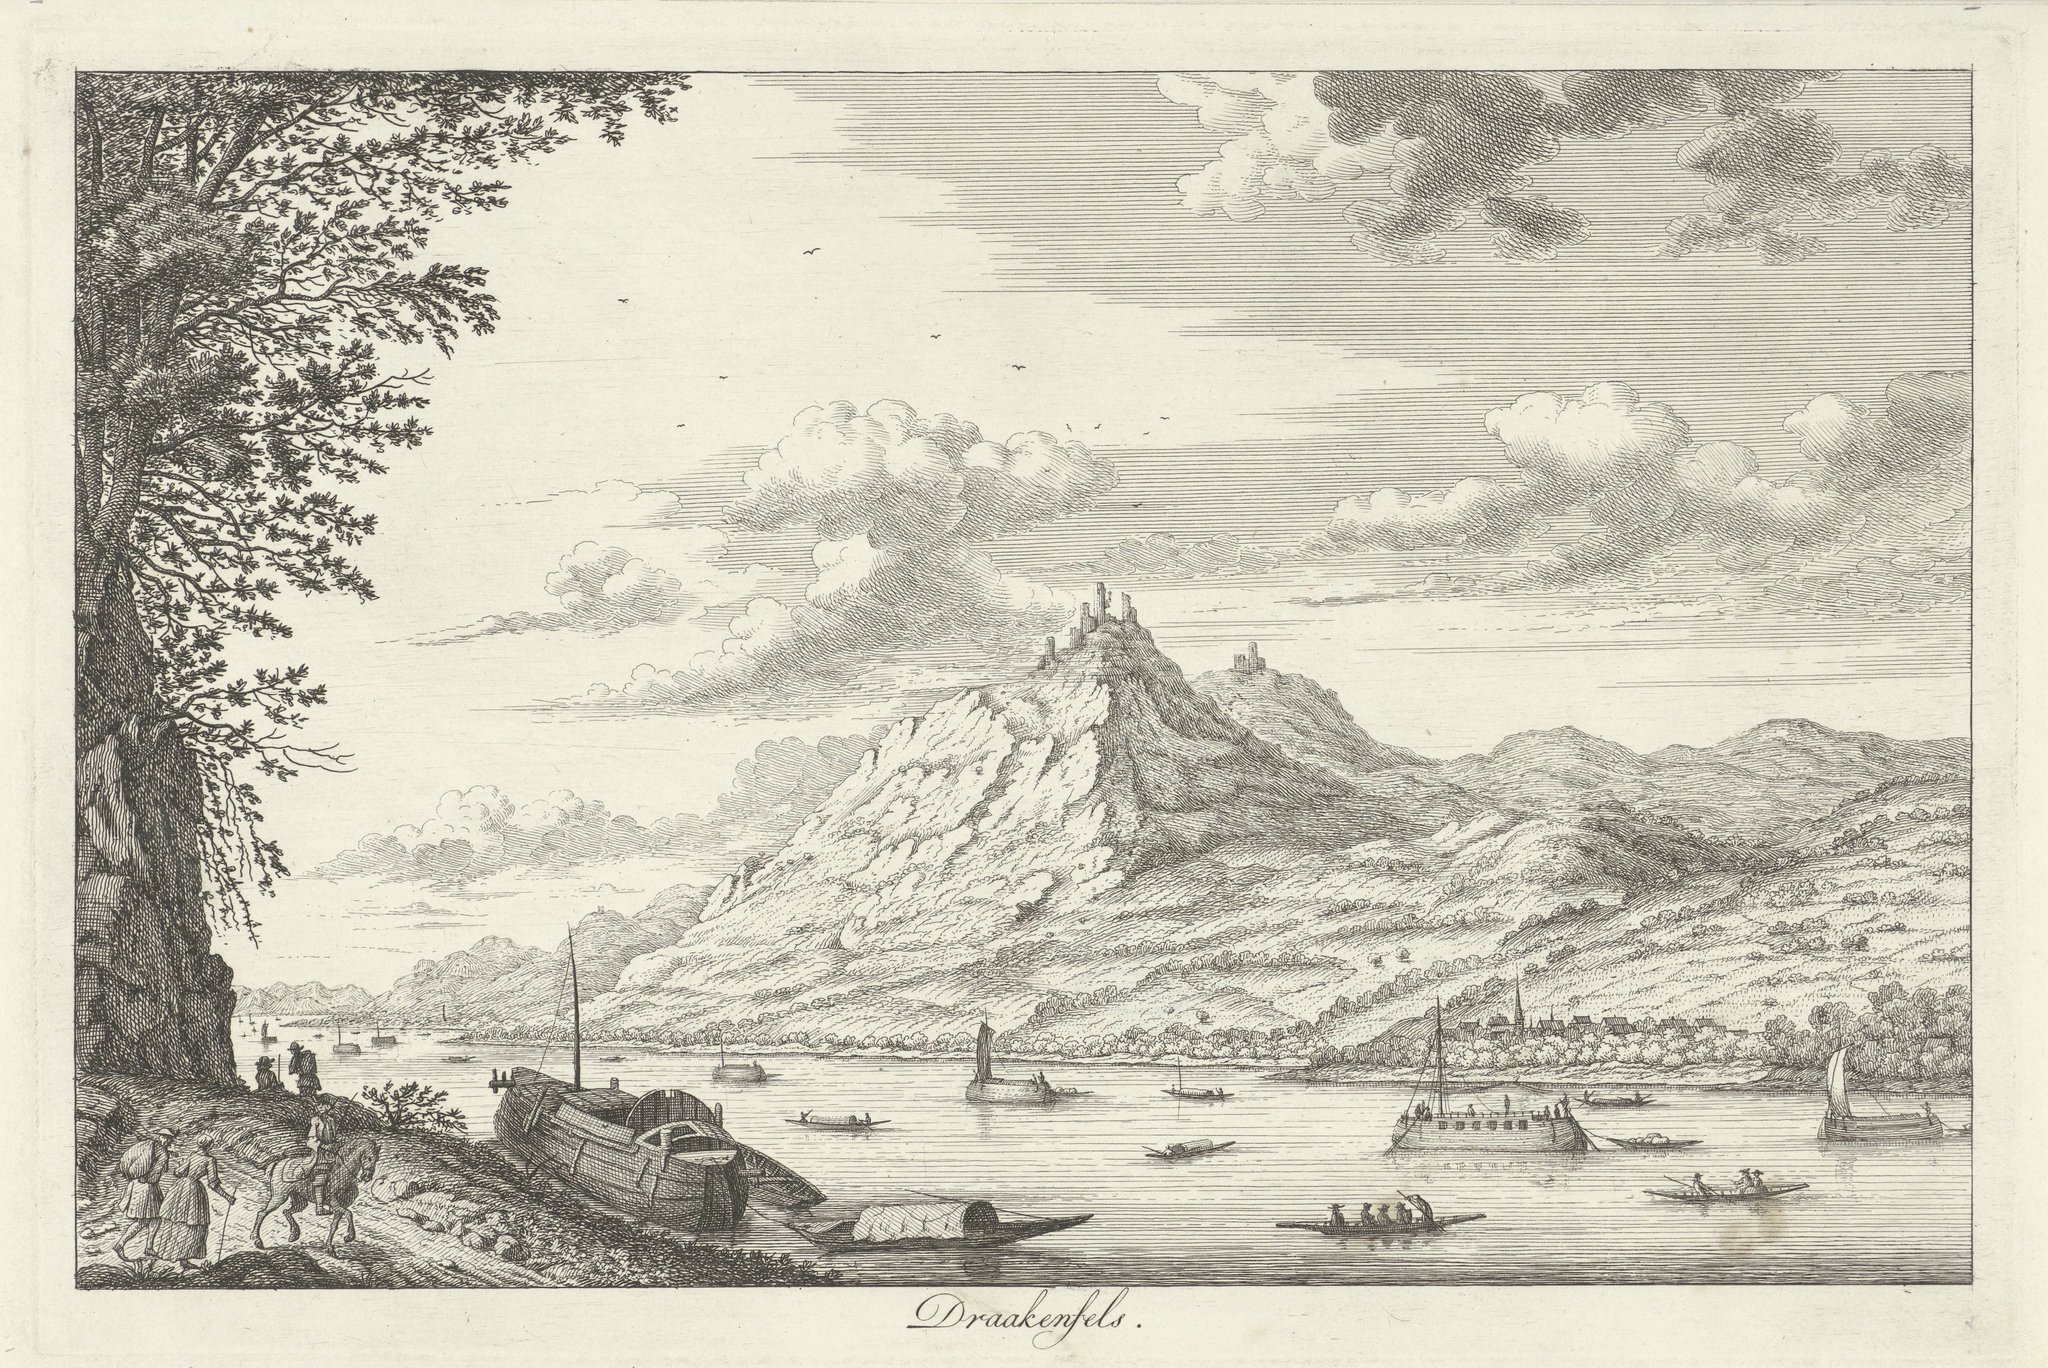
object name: print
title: Draakenfels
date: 1767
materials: paper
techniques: etching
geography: amsterdam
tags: river, ships (in general), mountains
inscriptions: collector's mark: Lugt 2228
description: Gezicht op de berg Drachenfels in het Zevengebergte, gezien vanaf de Rijn. De prent maakt deel uit van een elfdelige serie prenten met gezichten langs de Rijn.